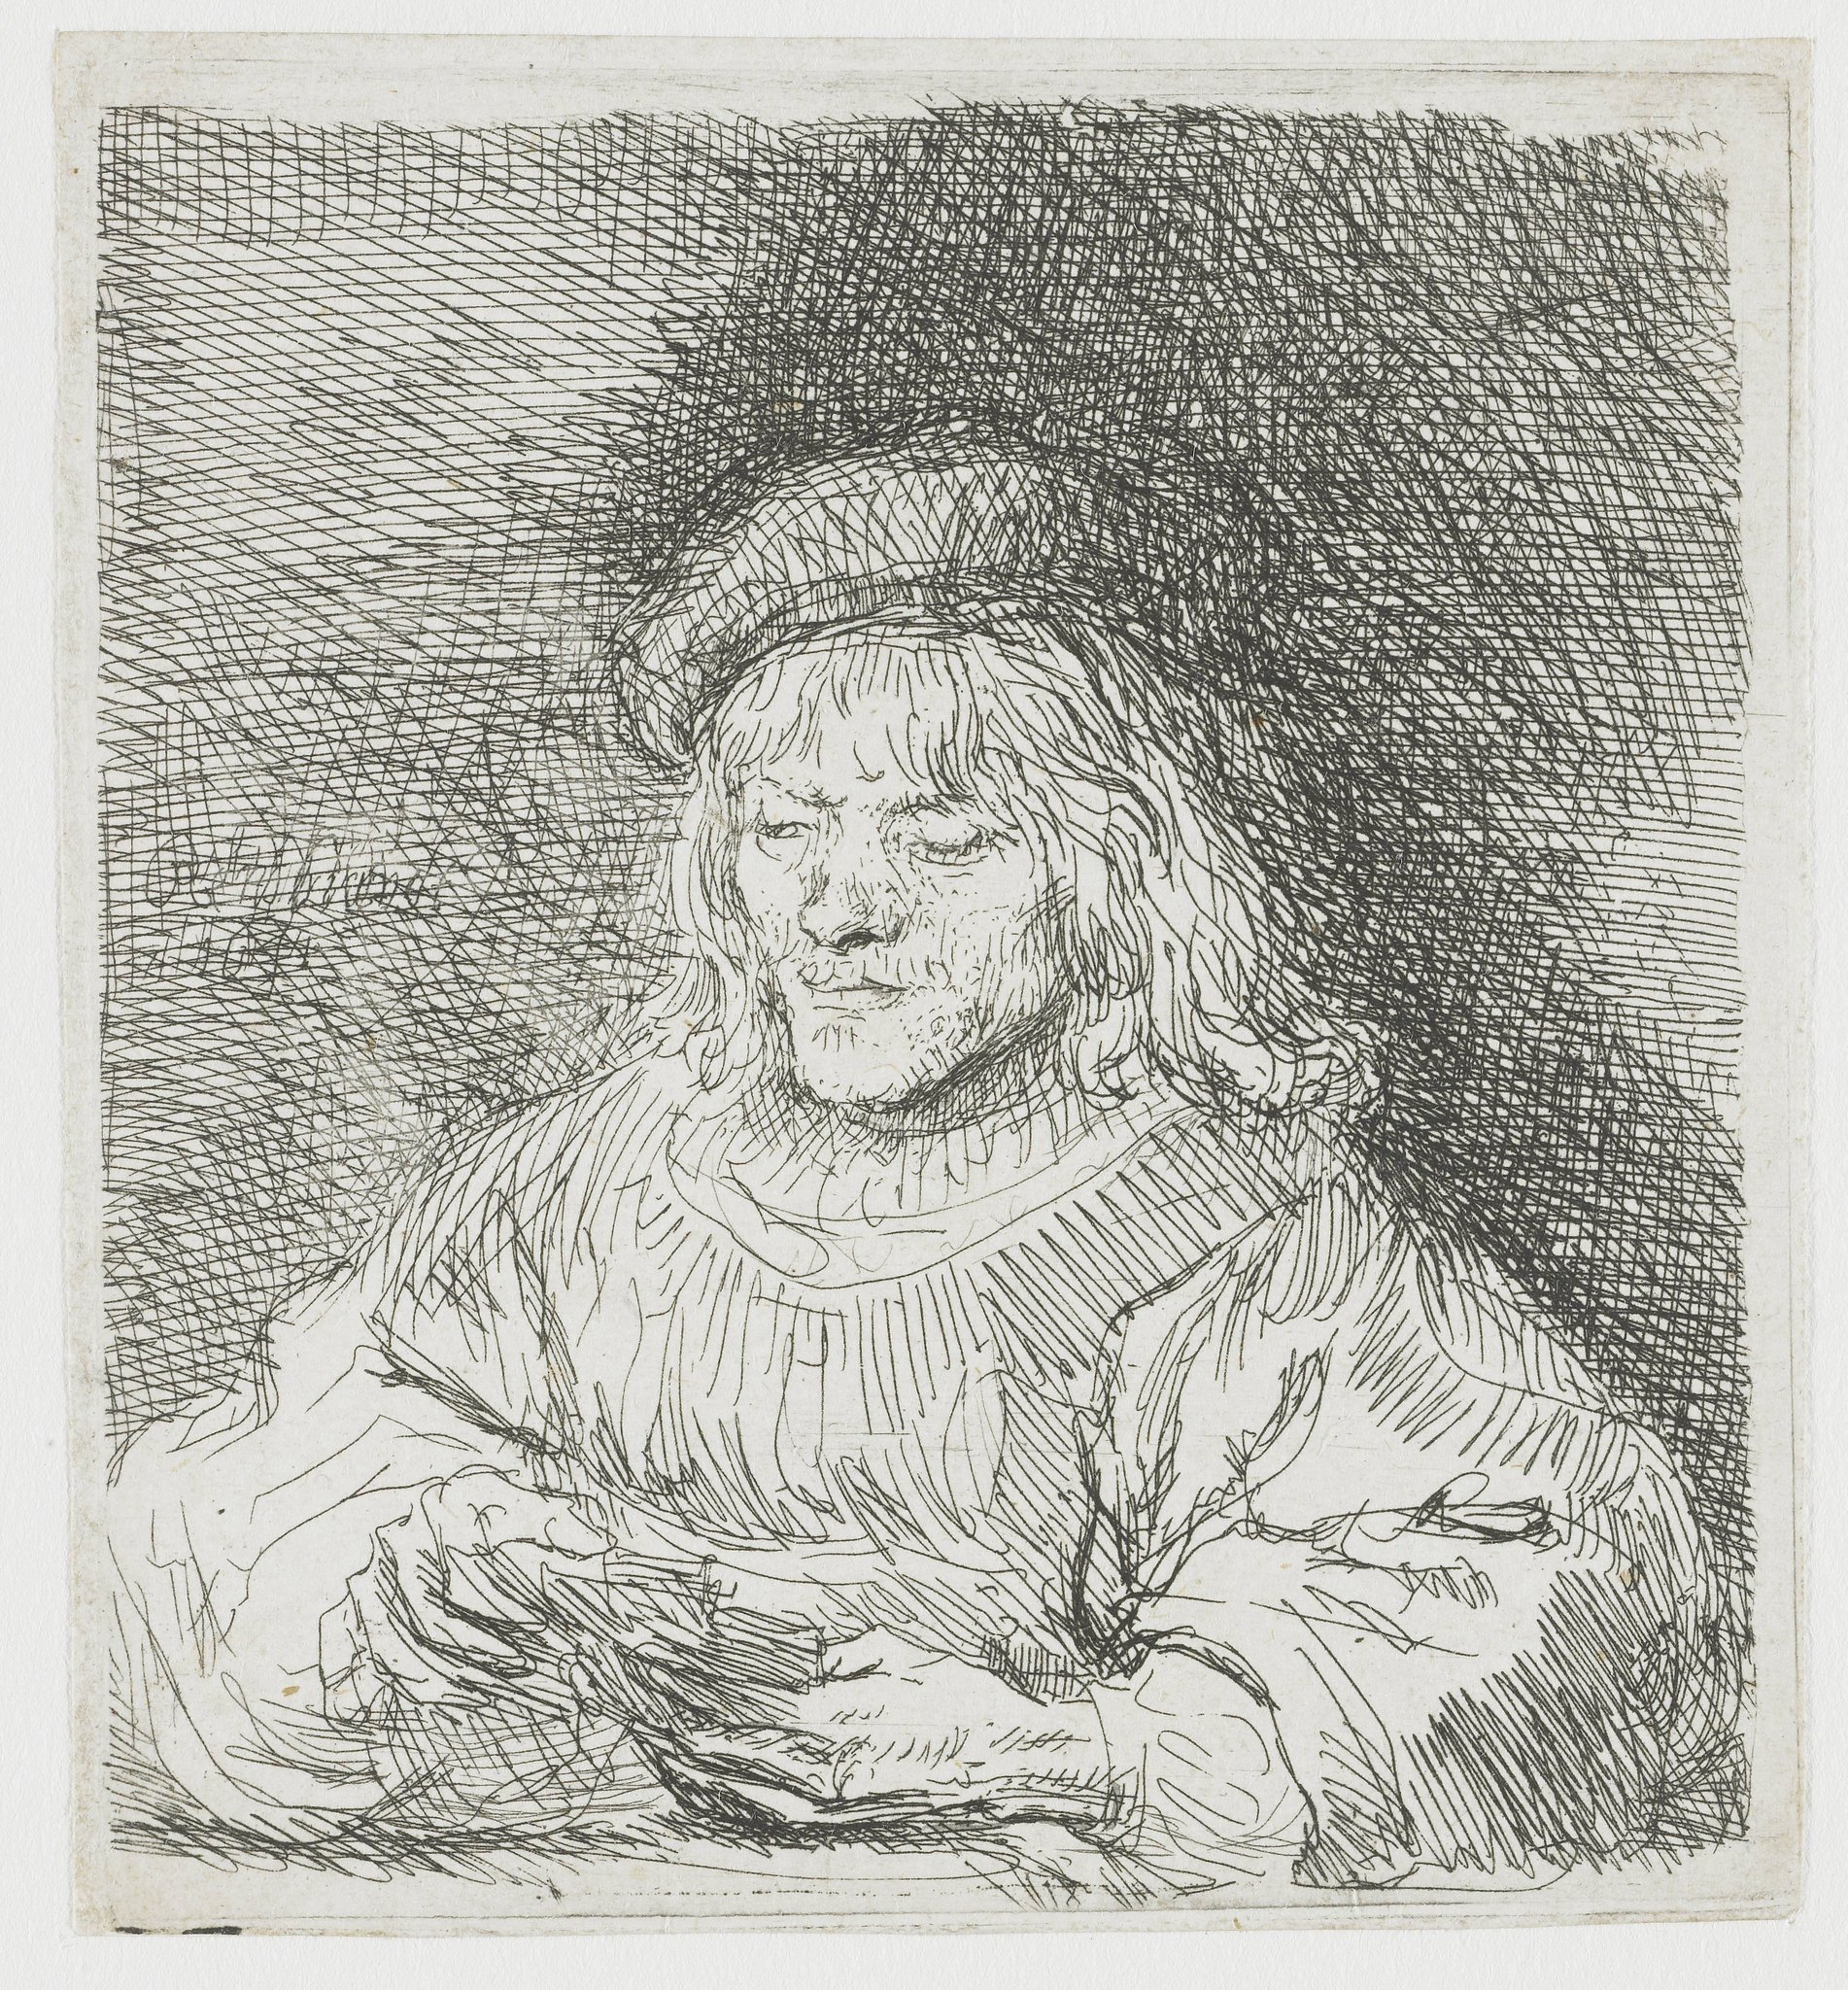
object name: print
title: The card player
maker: rembrandt van rijn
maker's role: draughtsman, painter, print maker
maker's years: 1606-1669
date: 1641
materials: paper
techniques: etching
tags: card games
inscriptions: signature and date: ‘Rembrandt f 1641’, mark, collector's mark: Lugt 2228